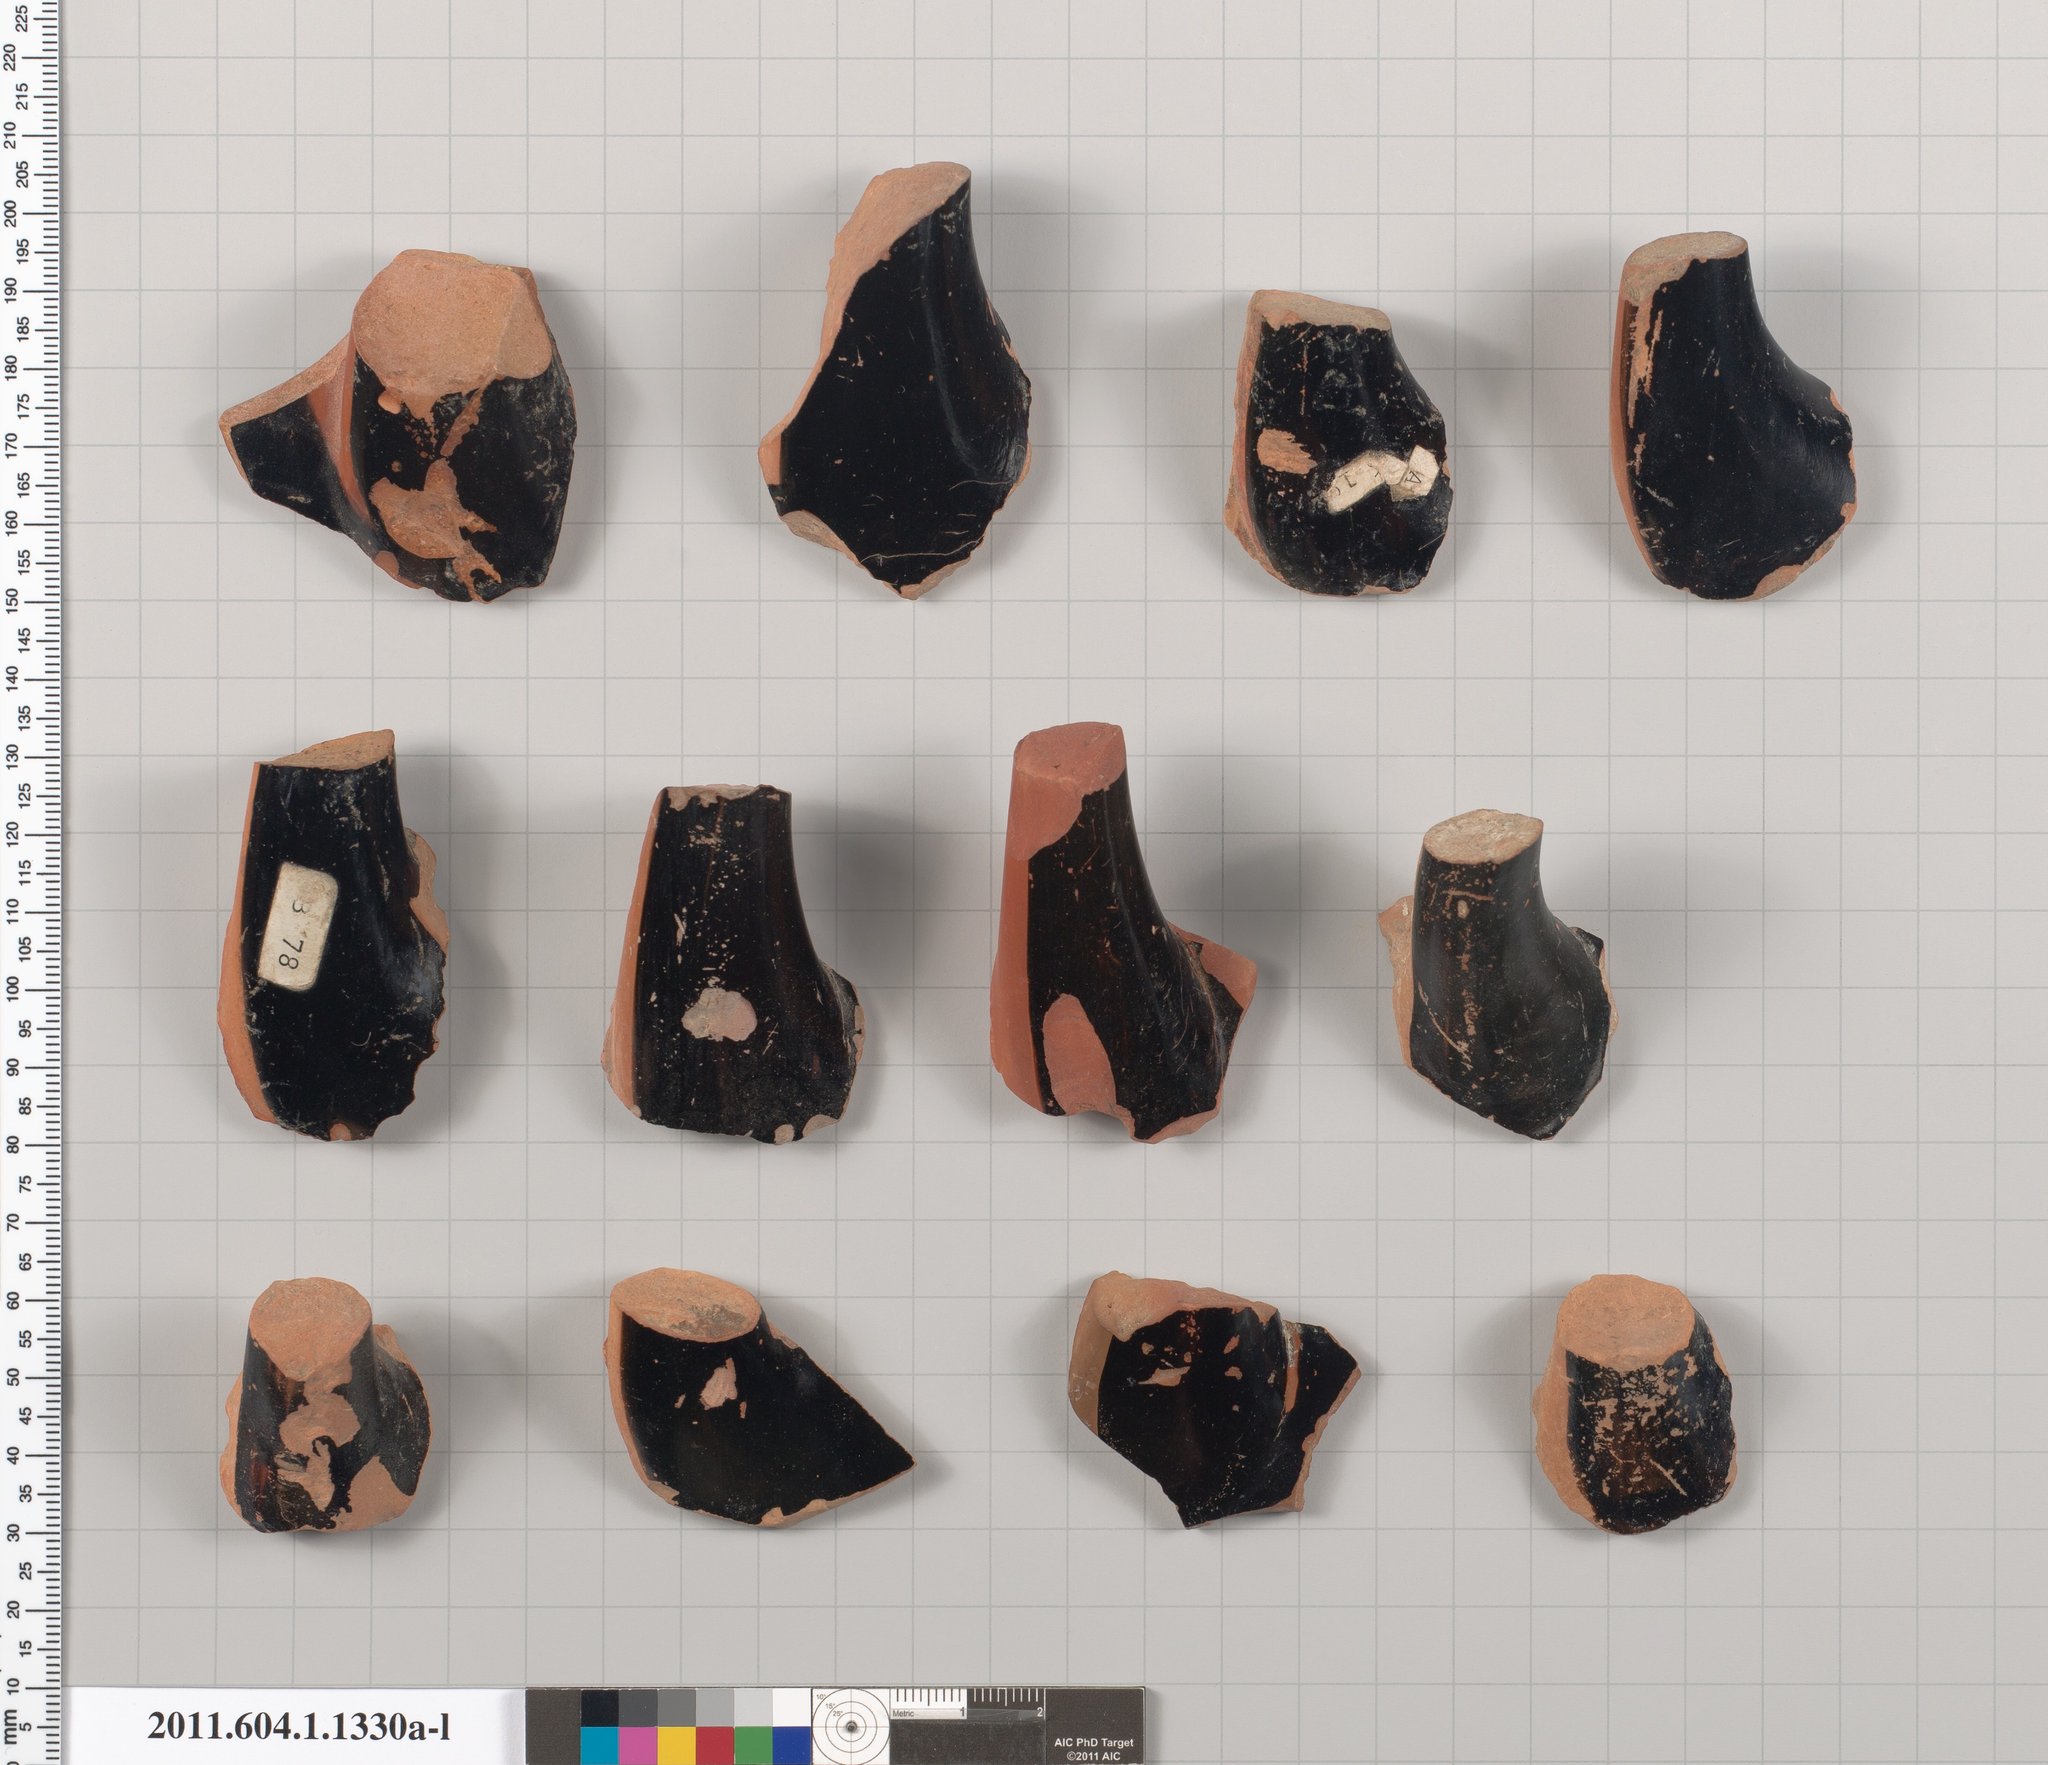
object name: kylix fragment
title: Terracotta fragments of kylikes (drinking cups)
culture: greek, attic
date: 500-401 BCE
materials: terracotta